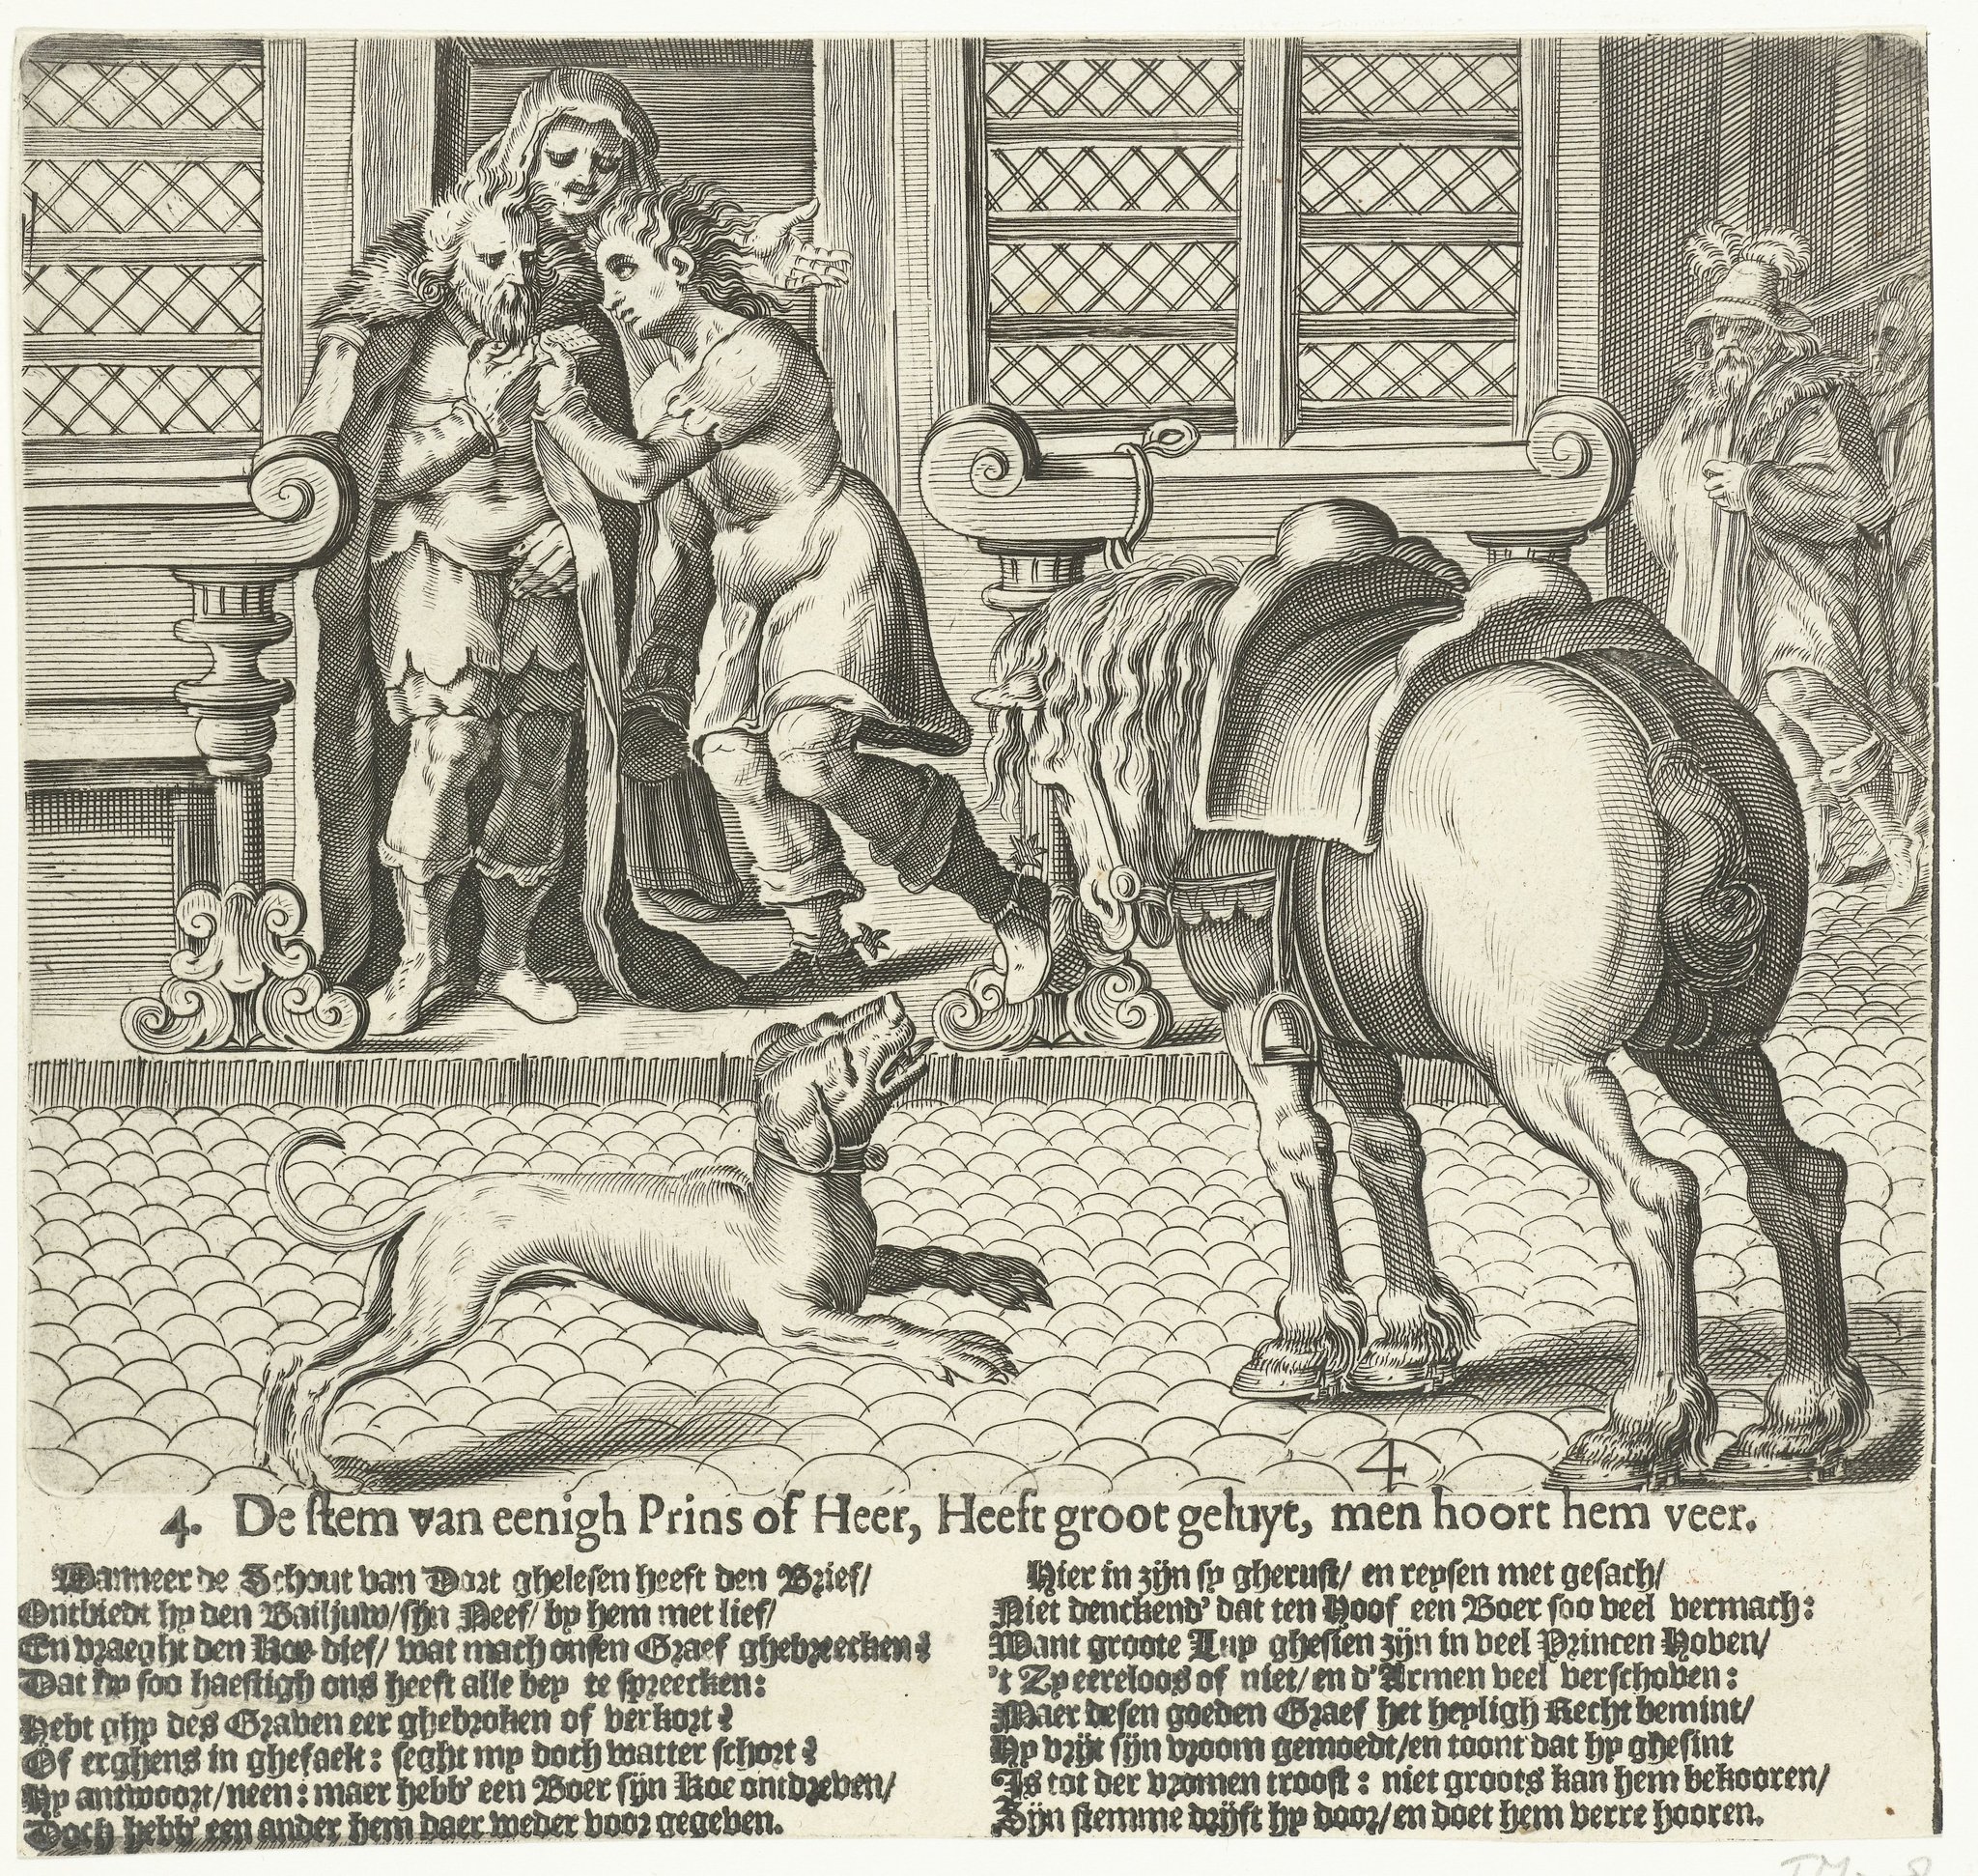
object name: history print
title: 4. De stem van eenigh Prins of Heer, Heeft groot geluyt, men hoort hem veer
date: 1613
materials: paper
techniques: engraving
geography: amsterdam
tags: willem iii de goede (graaf van holland en henegouwen), netherlands, dordrecht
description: De schout van Dordrecht ontvangt de brief van graaf Willem III waarin hij gevraagd wordt samen met de baljuw van Zuid-Holland naar het hof Valenciennes te komen. Voorstelling nr. 4 in een serie van zes kleine scènes van de opeenvolgende episoden van het verhaal van de Rechtspraak van graaf Willem III in het jaar 1336. Deze kleine prenten behoren aan weerszijden van de grote centrale voorstelling. Bij elke voorstelling een onderschrift bestaande uit een spreuk en een vers van twee kolommen van acht regels.